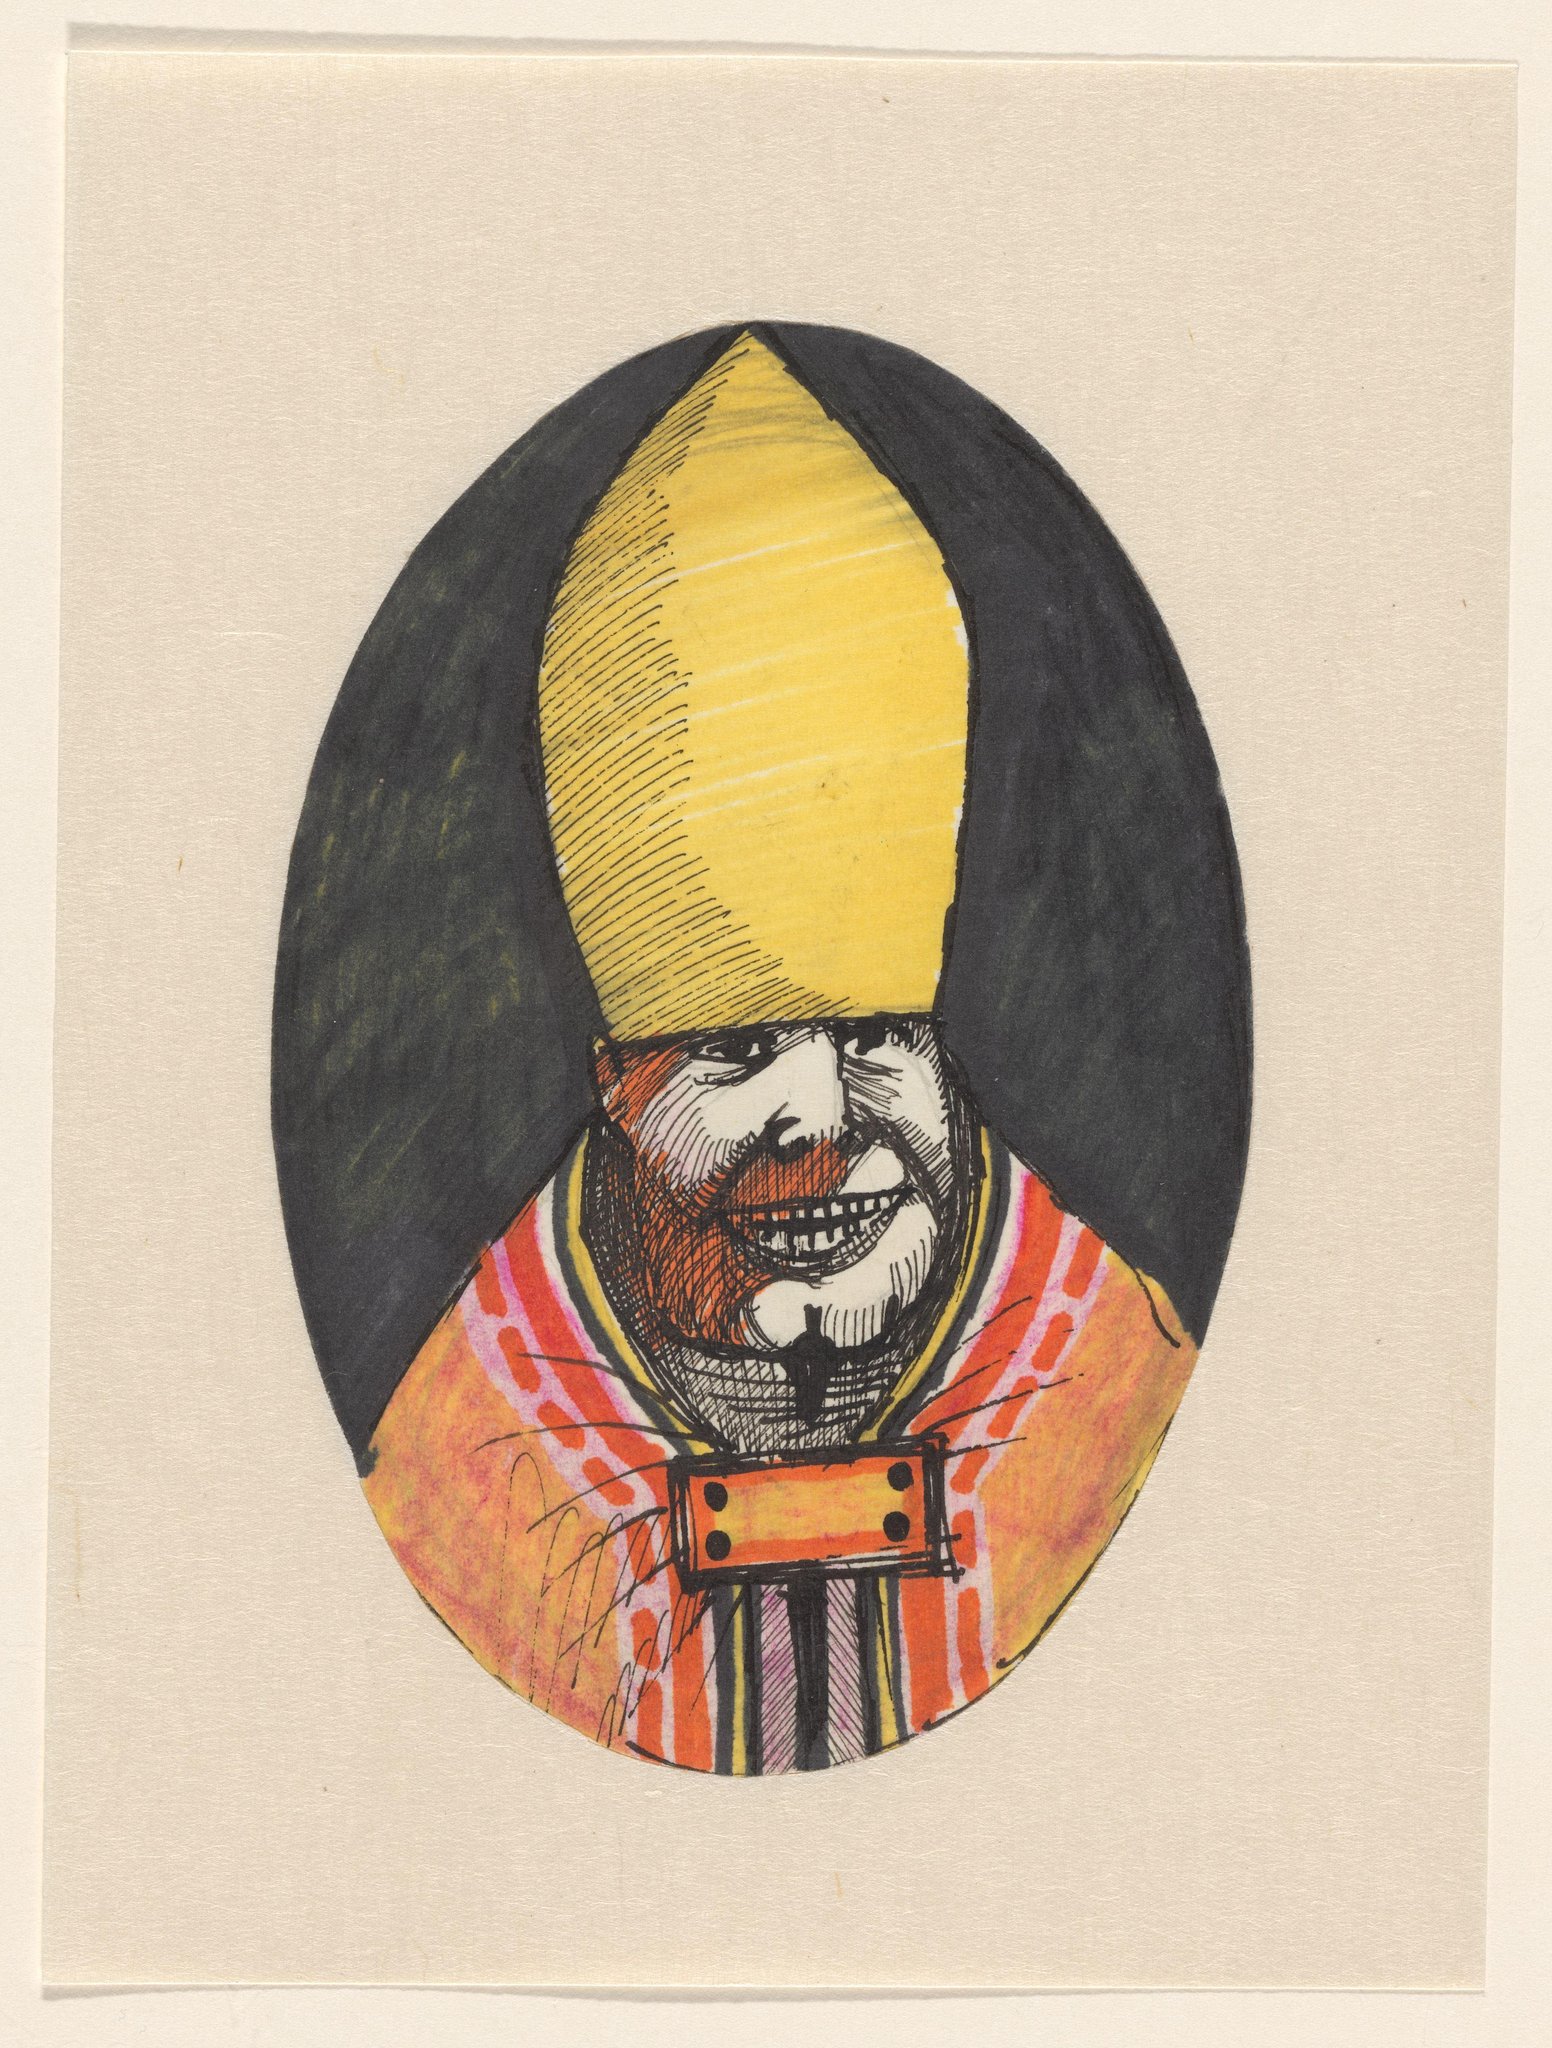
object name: drawing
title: Lachende man met mijter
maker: Anonymous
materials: ink, paper, pencil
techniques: drawing, pen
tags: insignia of bishop, e.g. mitre, crozier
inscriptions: : ‘Wijnberg?’